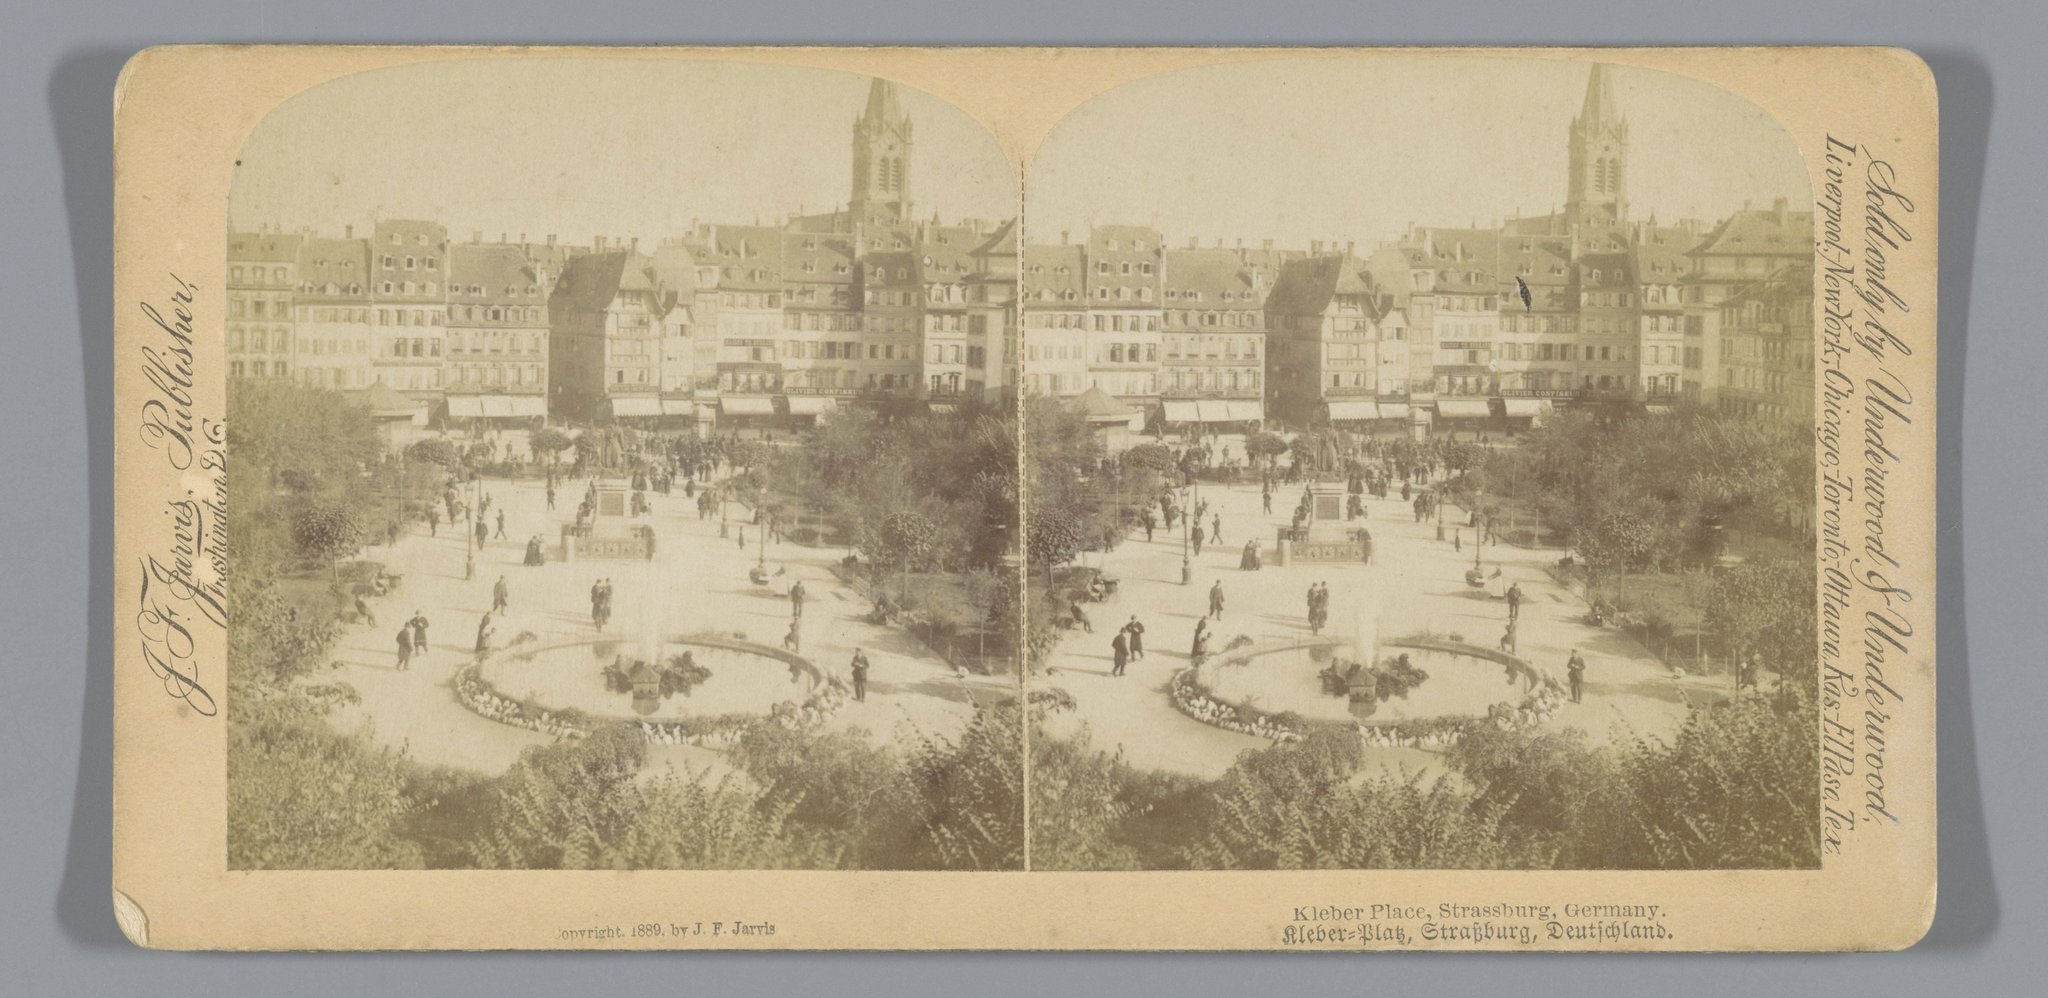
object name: stereograph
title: Gezicht op Place Kléber in Straatsburg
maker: john fillis jarvis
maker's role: publisher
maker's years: 1849-1931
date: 1889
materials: cardboard, photographic support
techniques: albumen print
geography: straatsburg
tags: square, place, circus, etc.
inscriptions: number: ‘54’